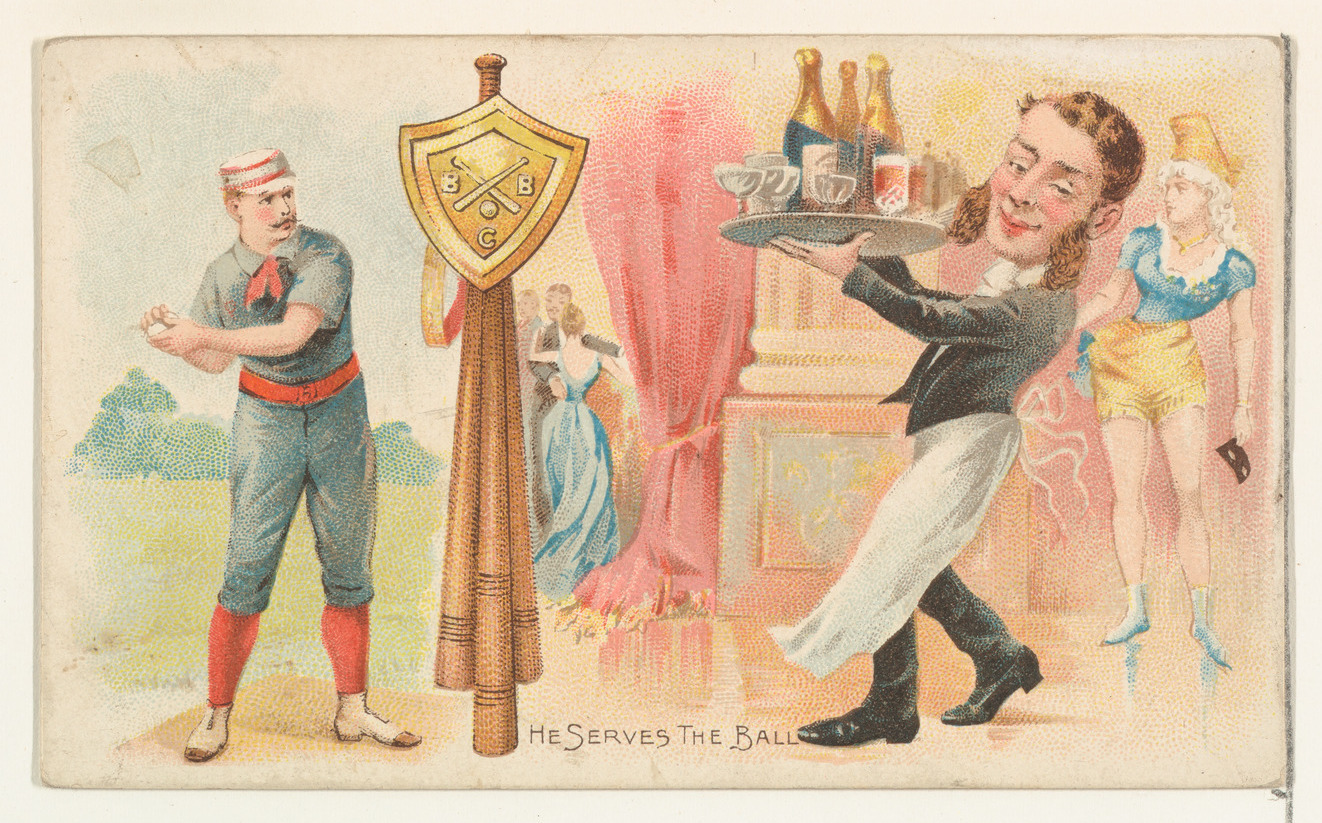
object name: print, baseball card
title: He Serves the Ball, from the Talk of the Diamond set (N135) issued by Duke Sons & Co., a branch of the American Tobacco Company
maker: w. duke, sons & co.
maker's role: publisher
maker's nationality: american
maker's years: 1870-1920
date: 1888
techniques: color lithograph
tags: men,women,baseball